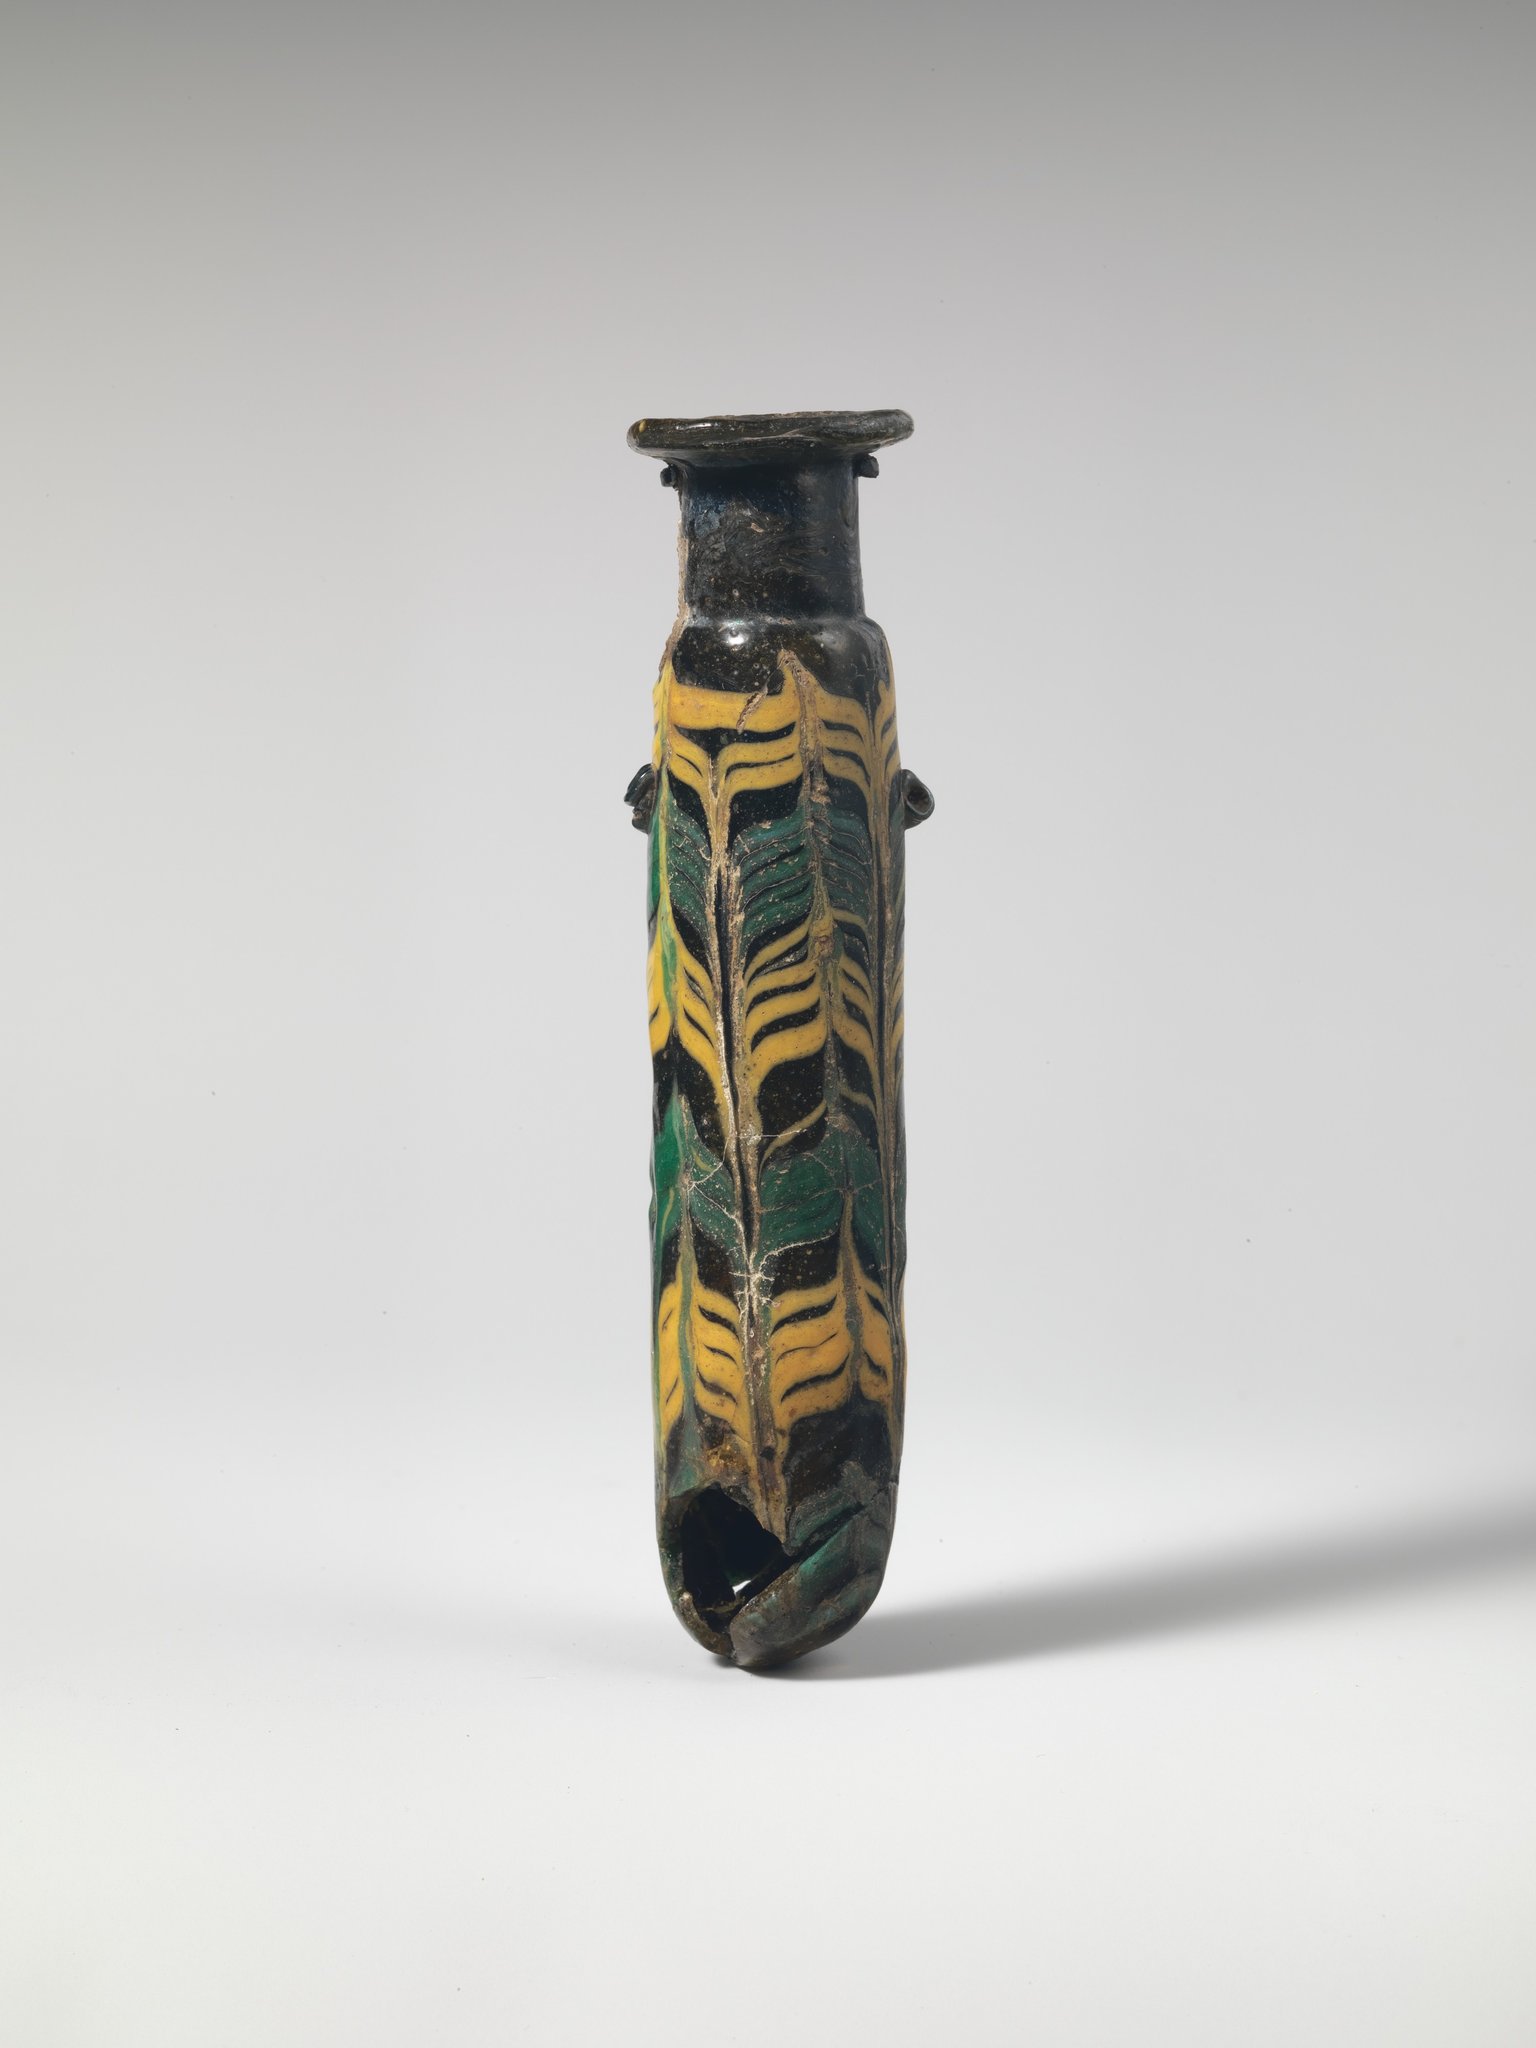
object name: alabastron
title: Glass alabastron (perfume bottle)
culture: greek, eastern mediterranean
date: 334-268 BCE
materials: glass